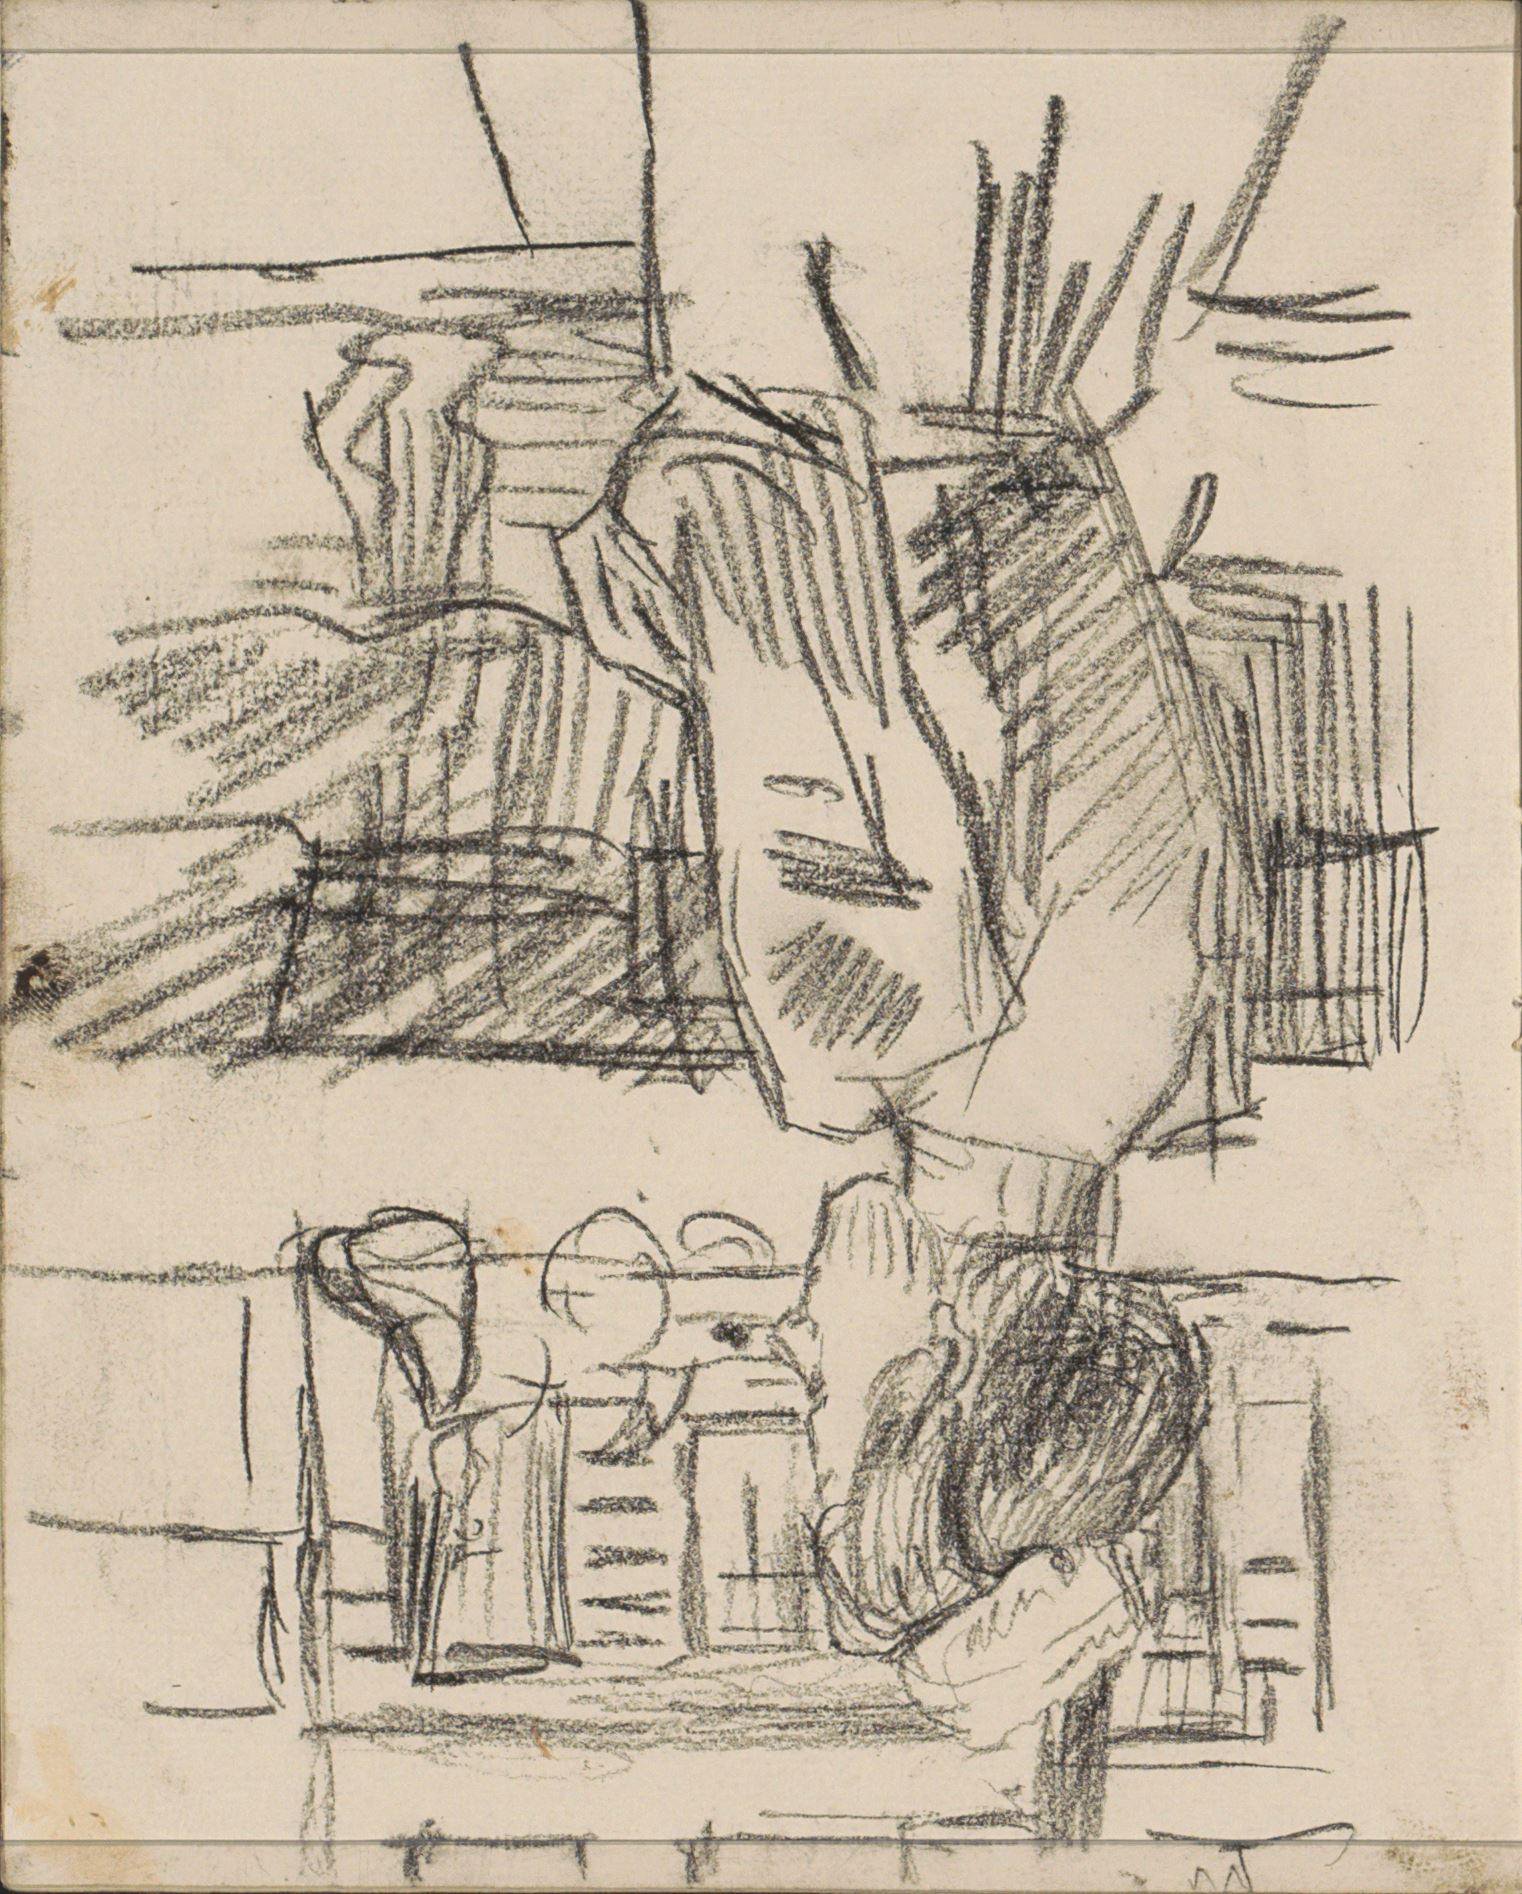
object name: sketchbook leaf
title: Dienstmeid op straat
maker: isaac israels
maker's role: draughtsman, painter, print maker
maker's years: 1865-1934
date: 1886-1903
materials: chalk, paper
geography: amsterdam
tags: maid ~ house personnel, street (+ city(-scape) with figures, staffage)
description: Mogelijk de Leidsegracht te Amsterdam. Pagina 14 uit schetsboek XXXII met 92 pagina's.